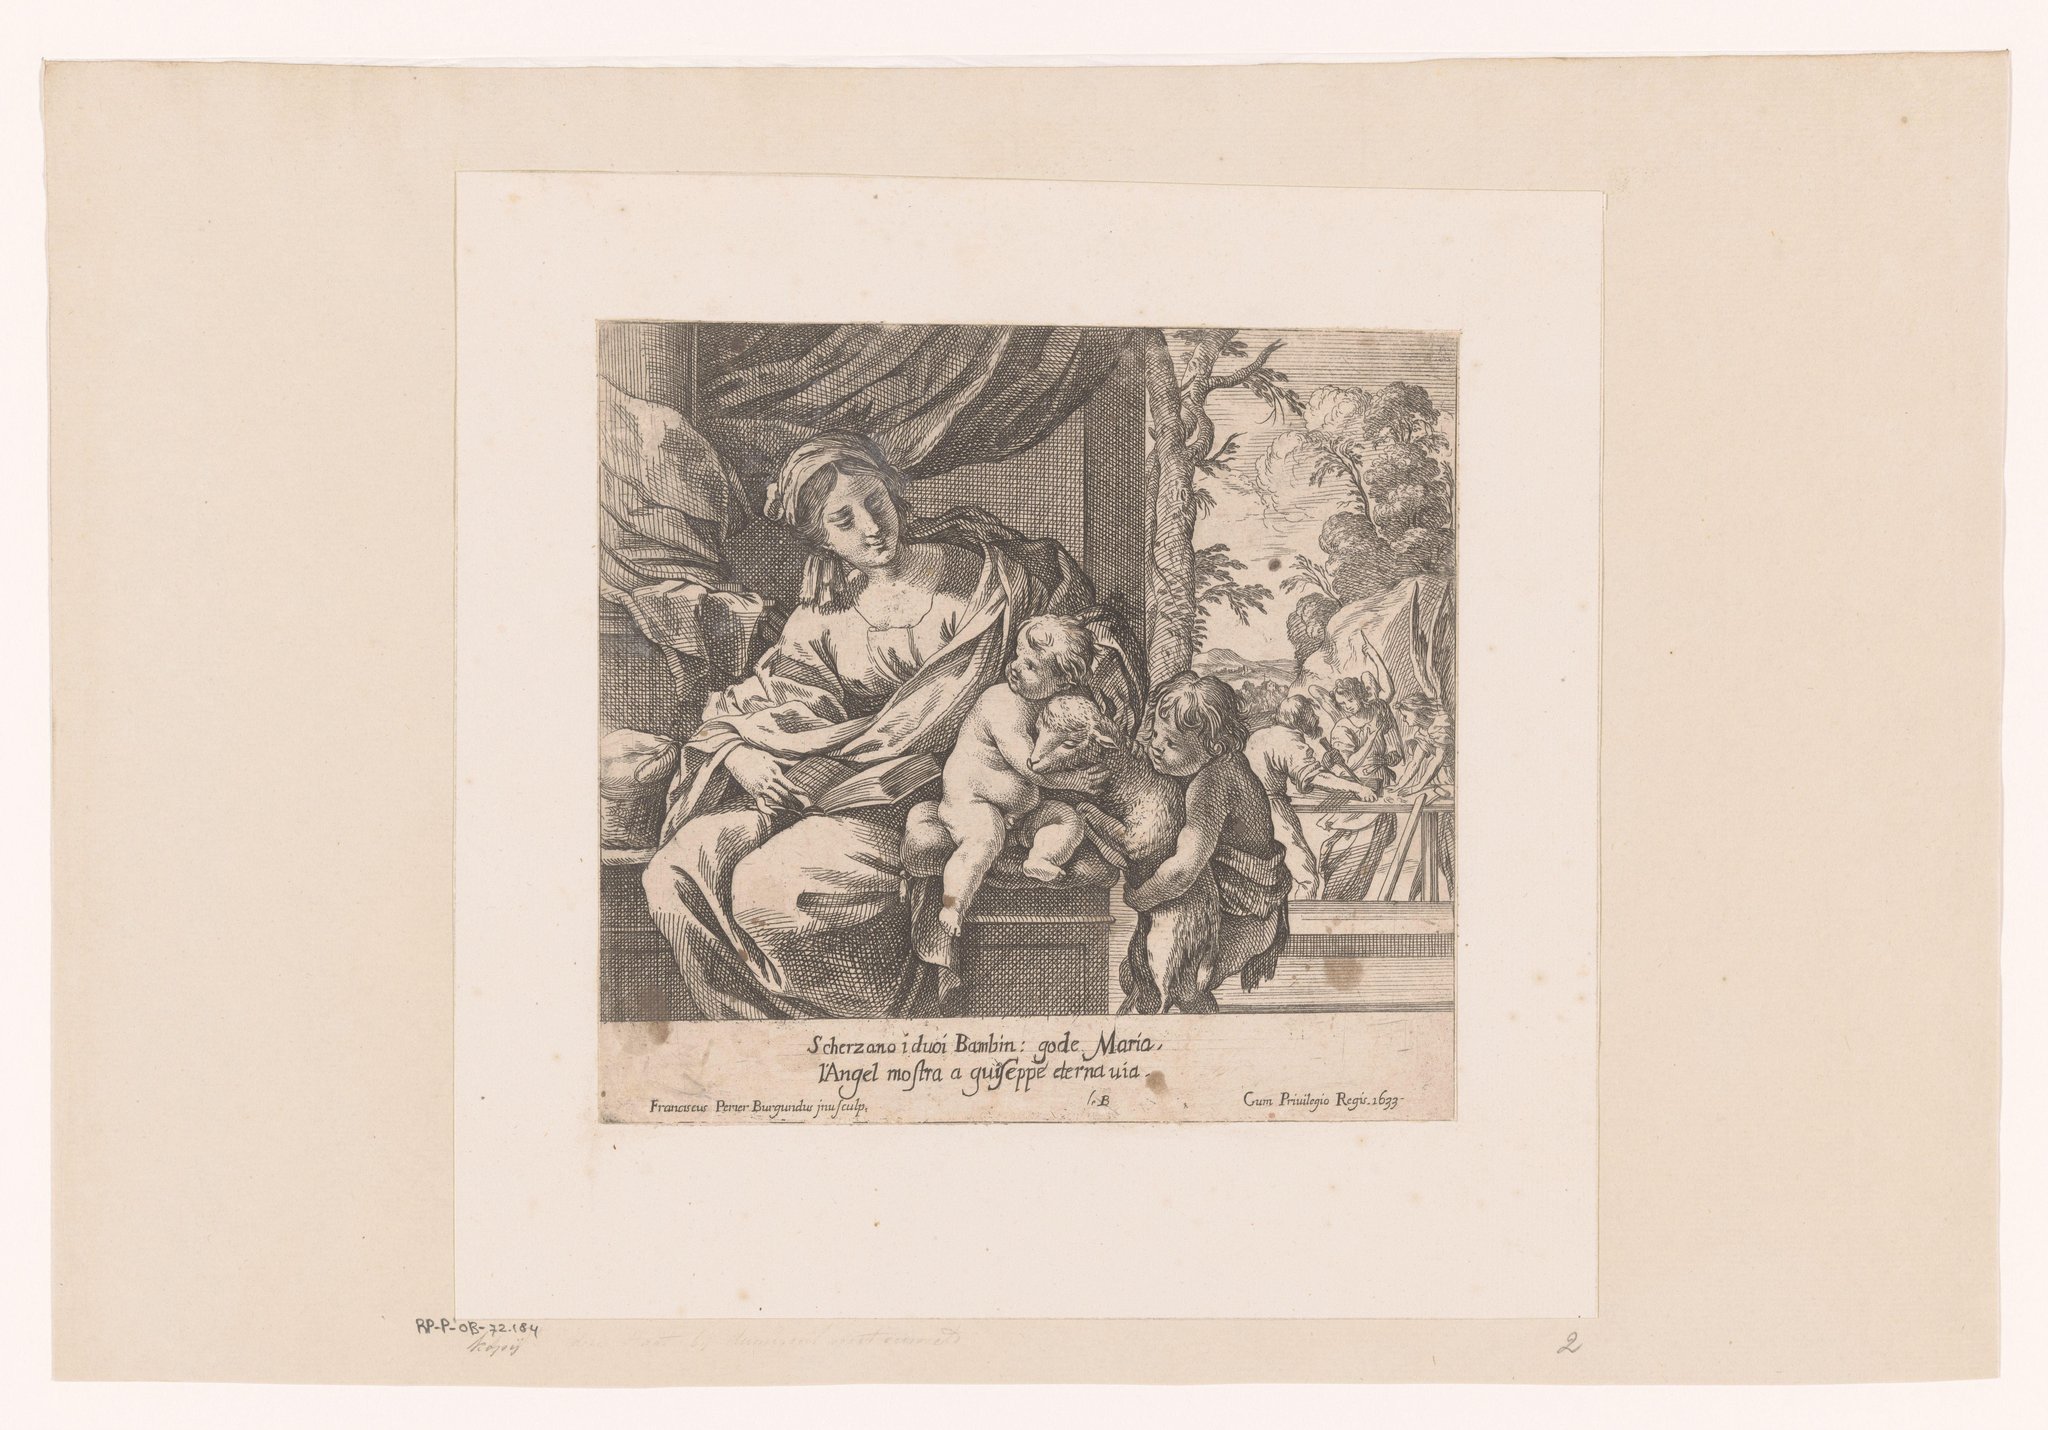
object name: print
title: Maria met kind, Johannes de Doper en lam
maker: Anonymous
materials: paper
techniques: etching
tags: mary and the christ-child with john the baptist (as child), christ-child playing with lamb ~ madonna-representations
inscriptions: collector's mark: Lugt 240